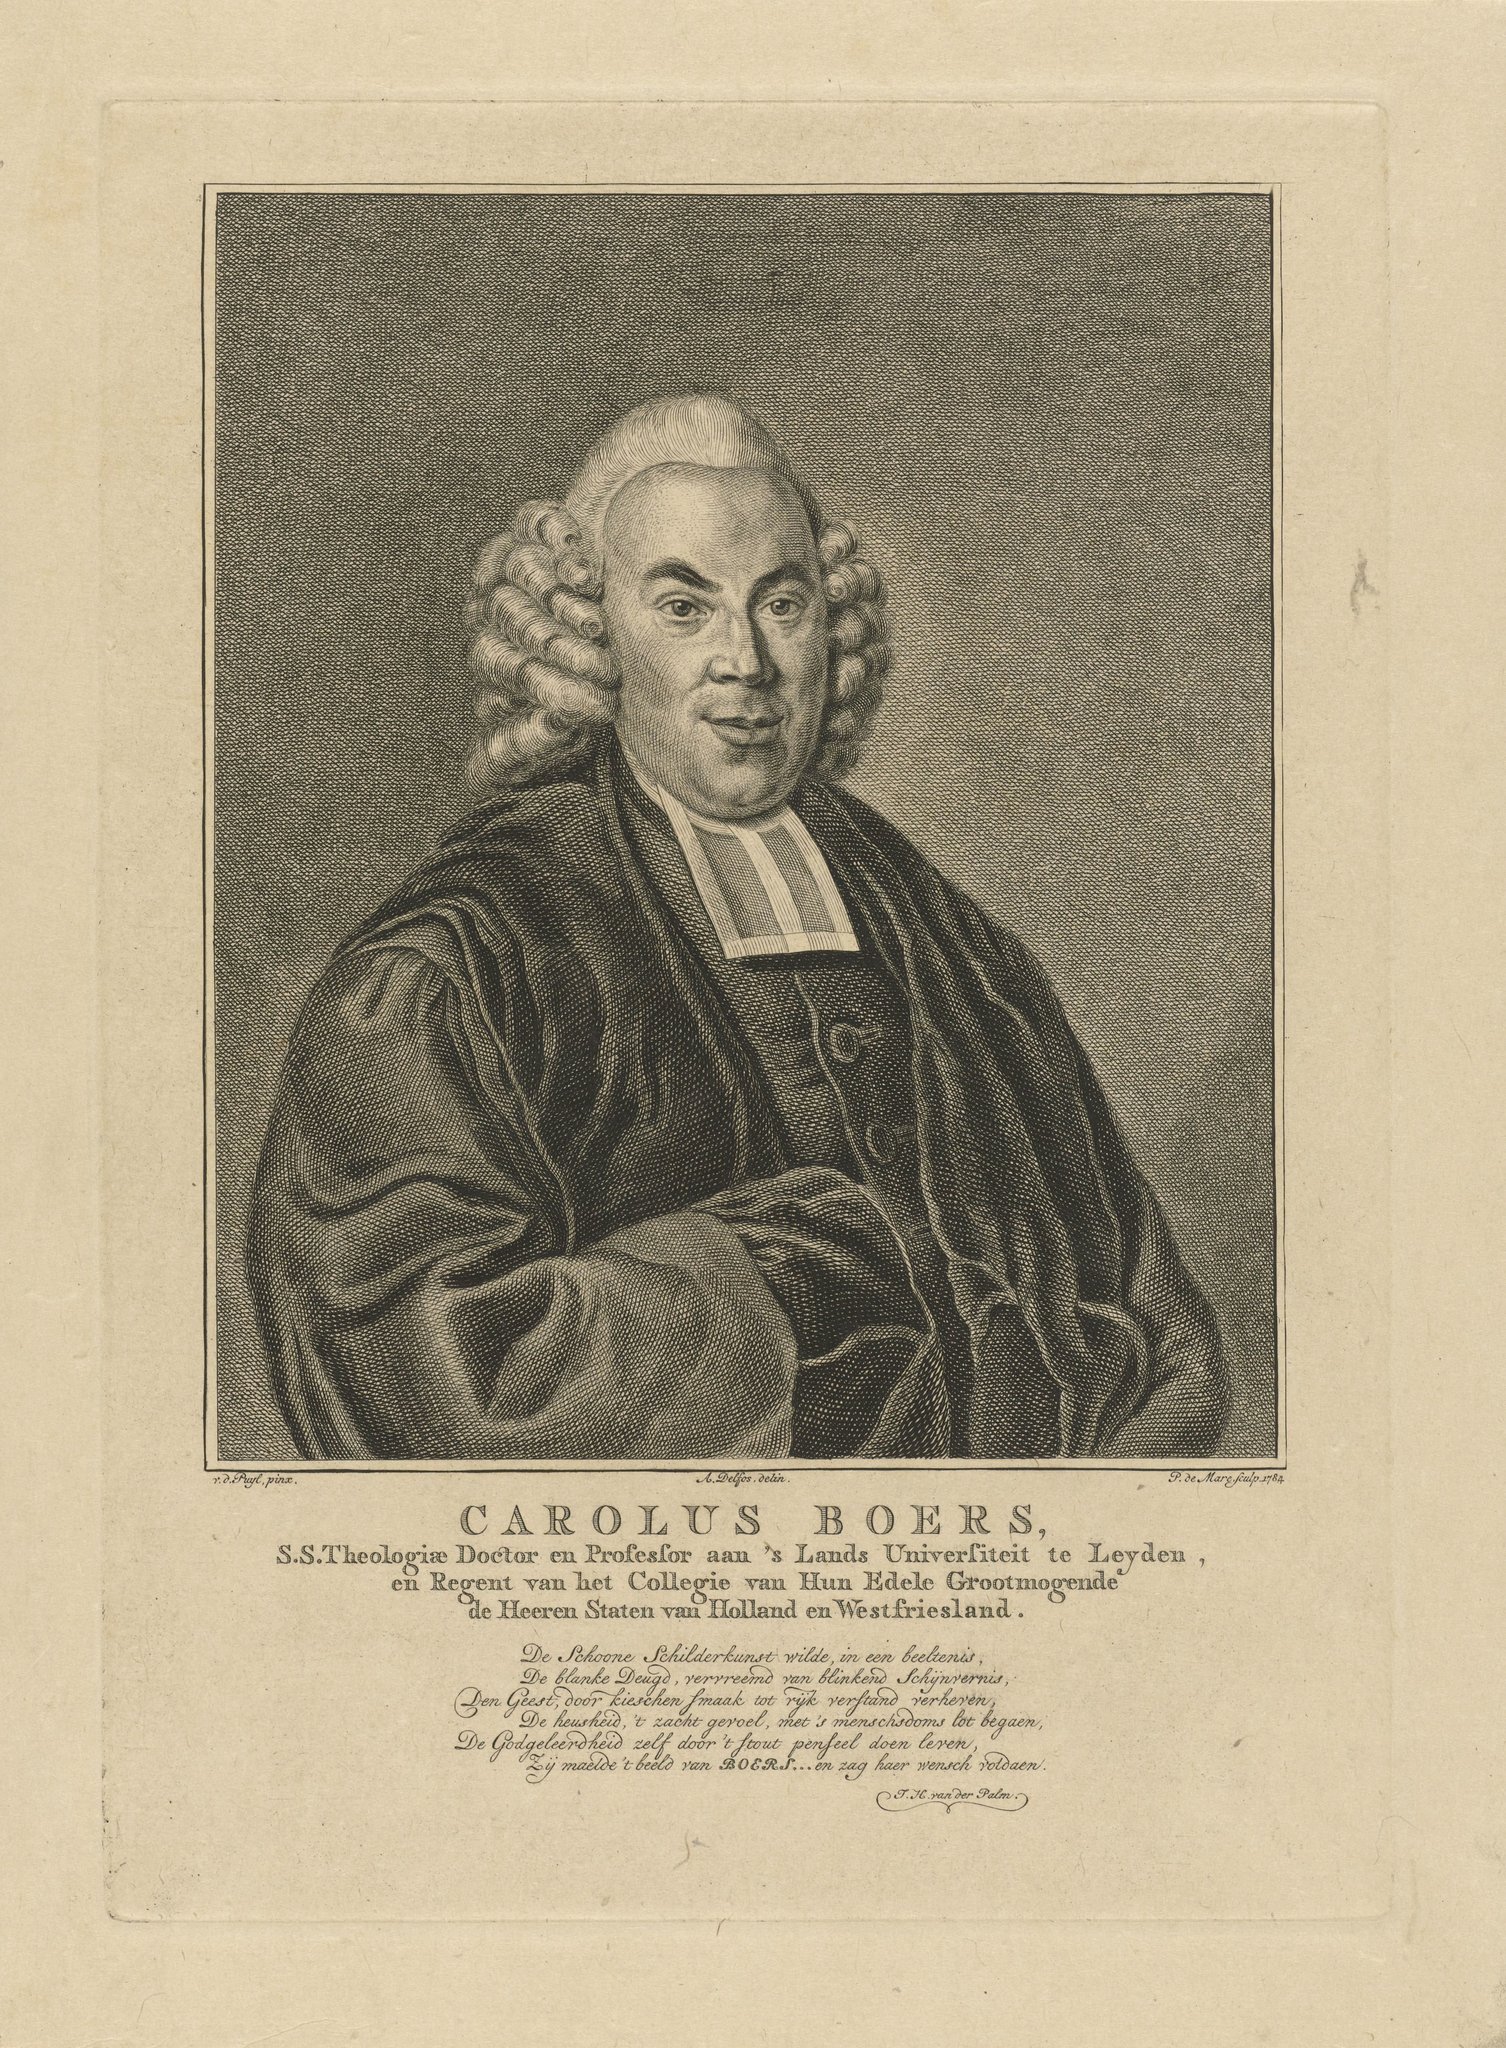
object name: print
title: Portret van Carolus Boers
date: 1784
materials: paper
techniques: engraving, etching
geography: leiden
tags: leiden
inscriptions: collector's mark: Lugt 240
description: Portret van de Leidse theoloog Carolus Boers.